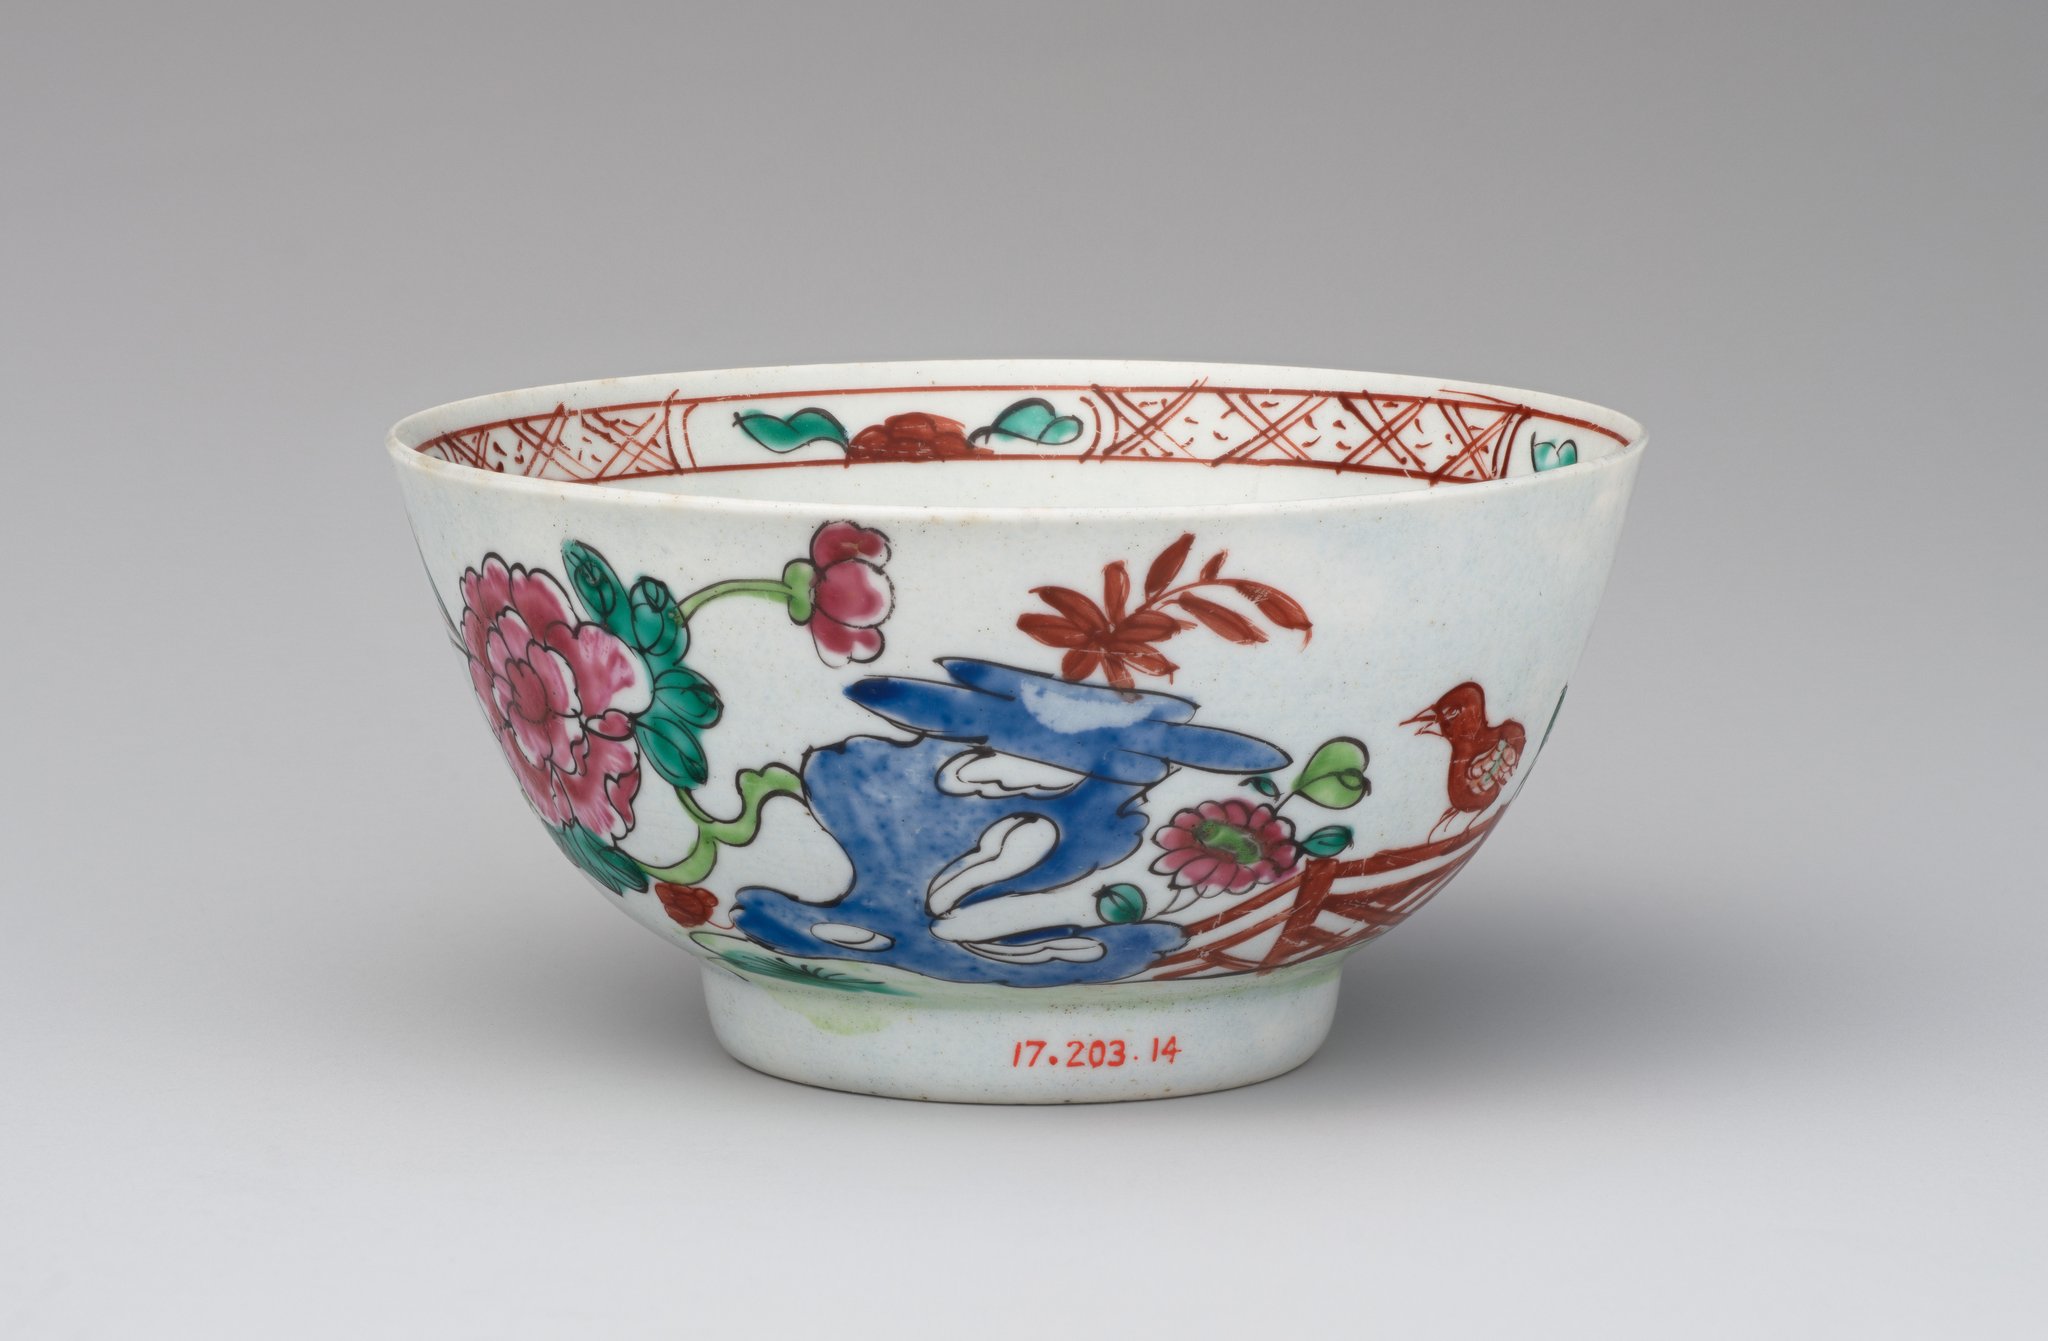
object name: bowl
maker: bow porcelain factory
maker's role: factory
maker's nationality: british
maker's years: 1747-1776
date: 1770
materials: soft paste porcelain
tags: birds